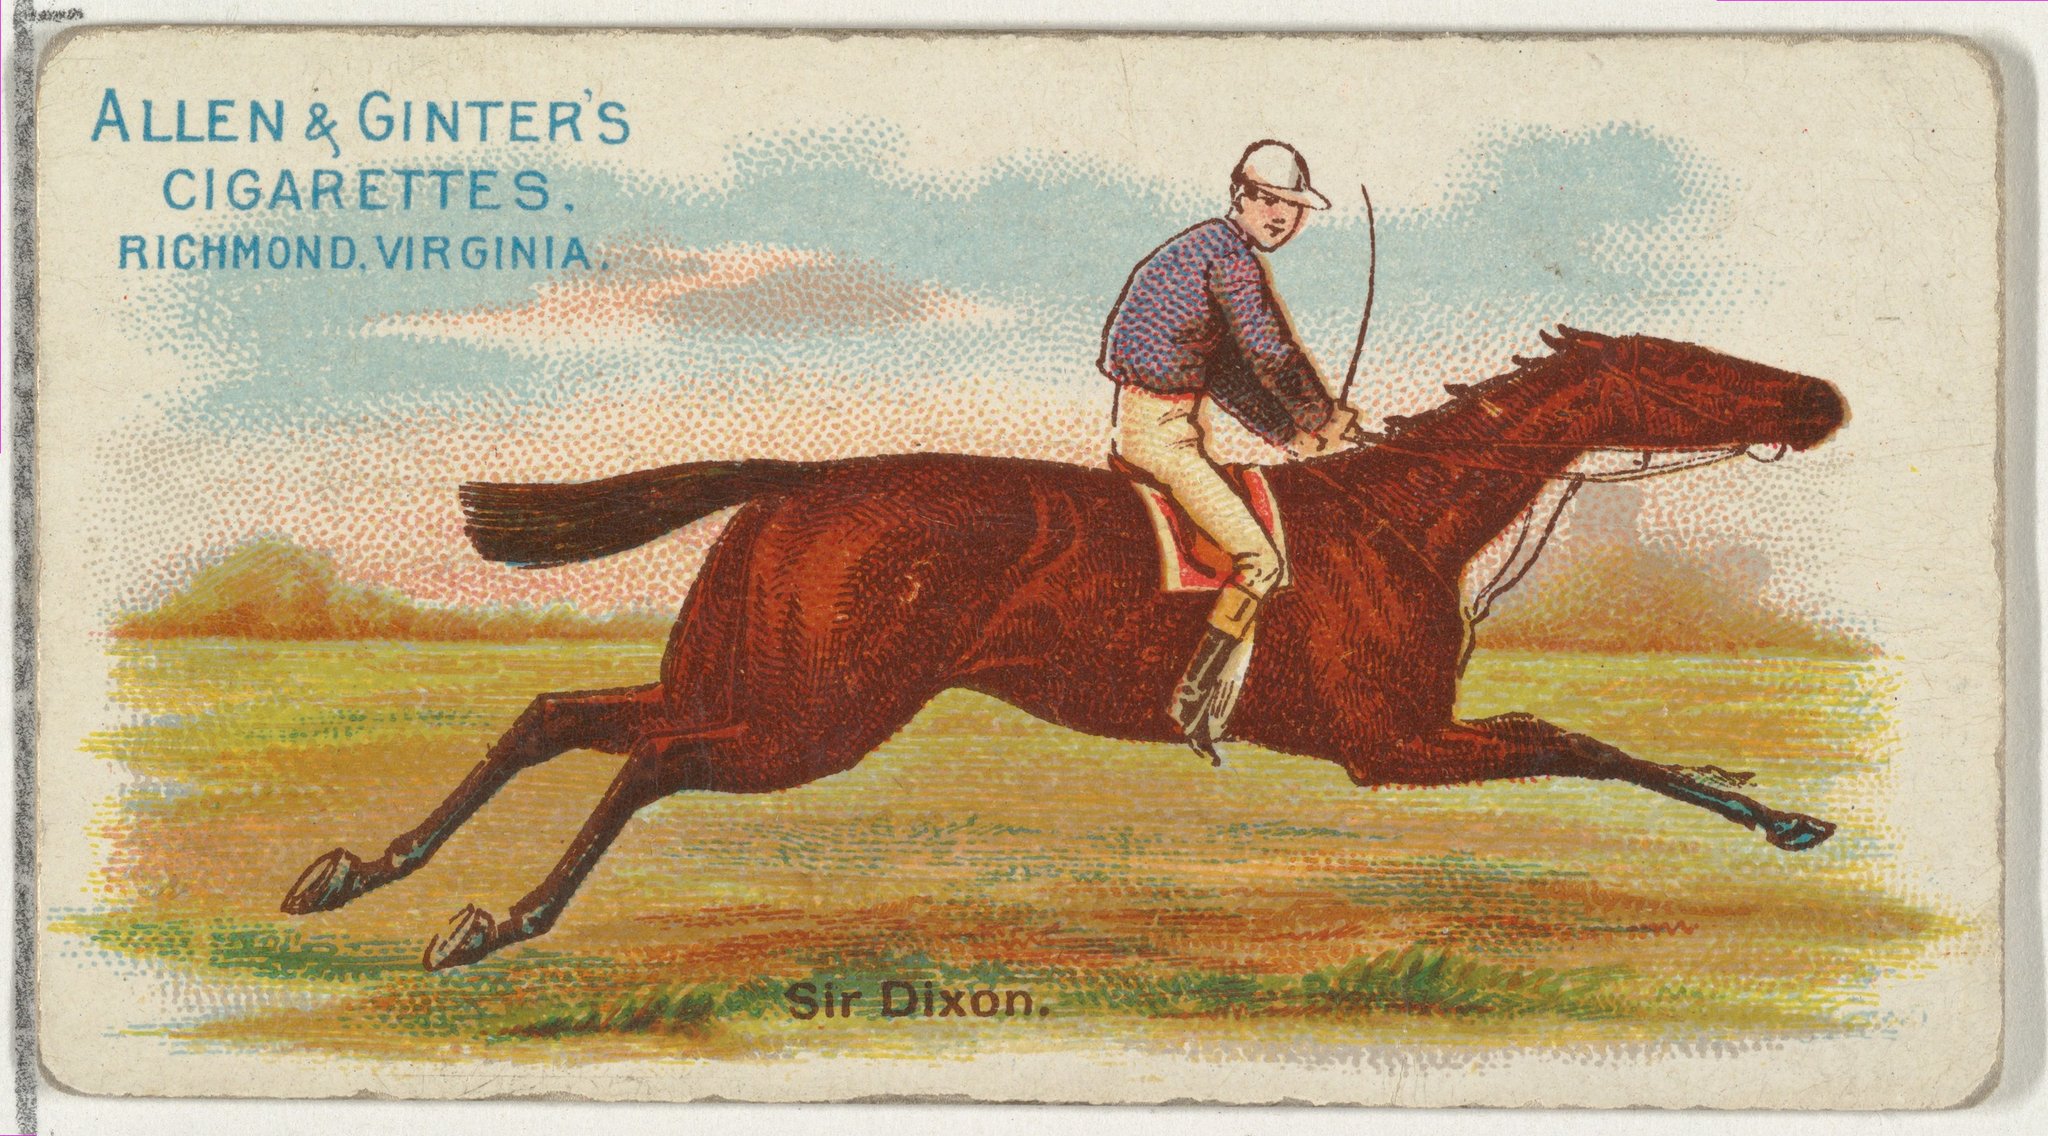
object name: print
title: Sir Dixon, from The World's Racers series (N32) for Allen & Ginter Cigarettes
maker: allen & ginter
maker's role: publisher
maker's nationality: american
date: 1888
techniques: color lithograph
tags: men,horses,jockeys